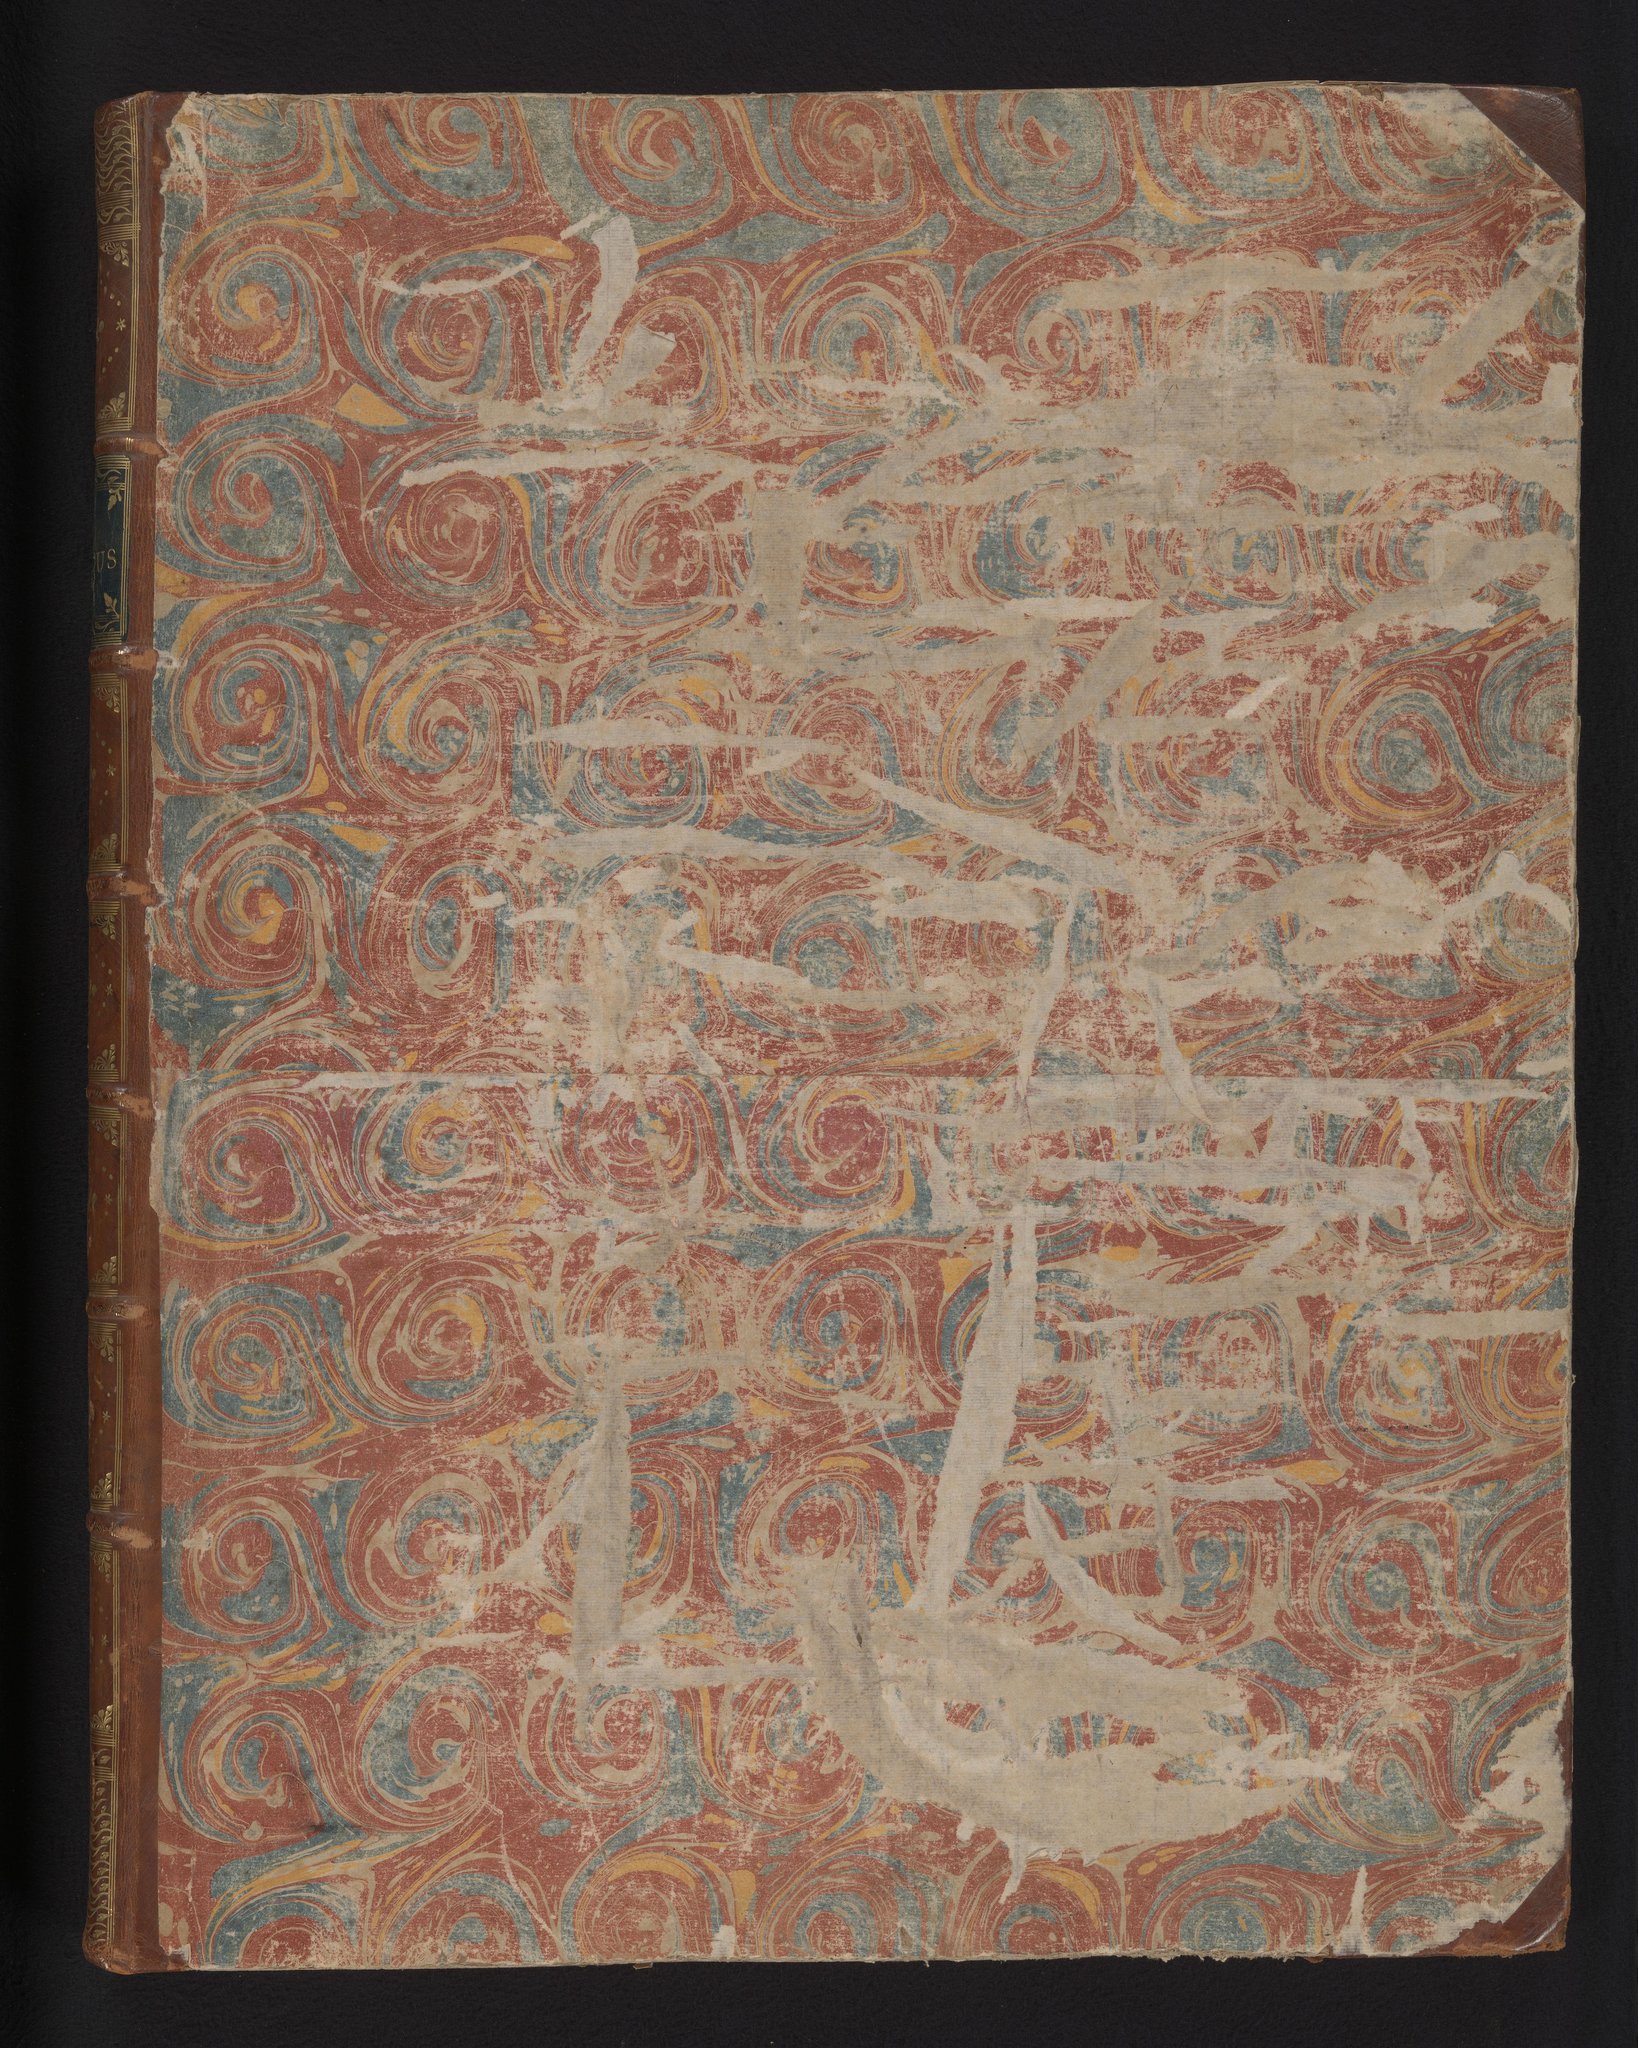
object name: prentrecueil, prentenalbum, prentalbum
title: Leeg prentalbum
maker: Anonymous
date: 1750-1850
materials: leather, cardboard, paper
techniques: bookbinding, printing, marbling, marbled paper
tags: book